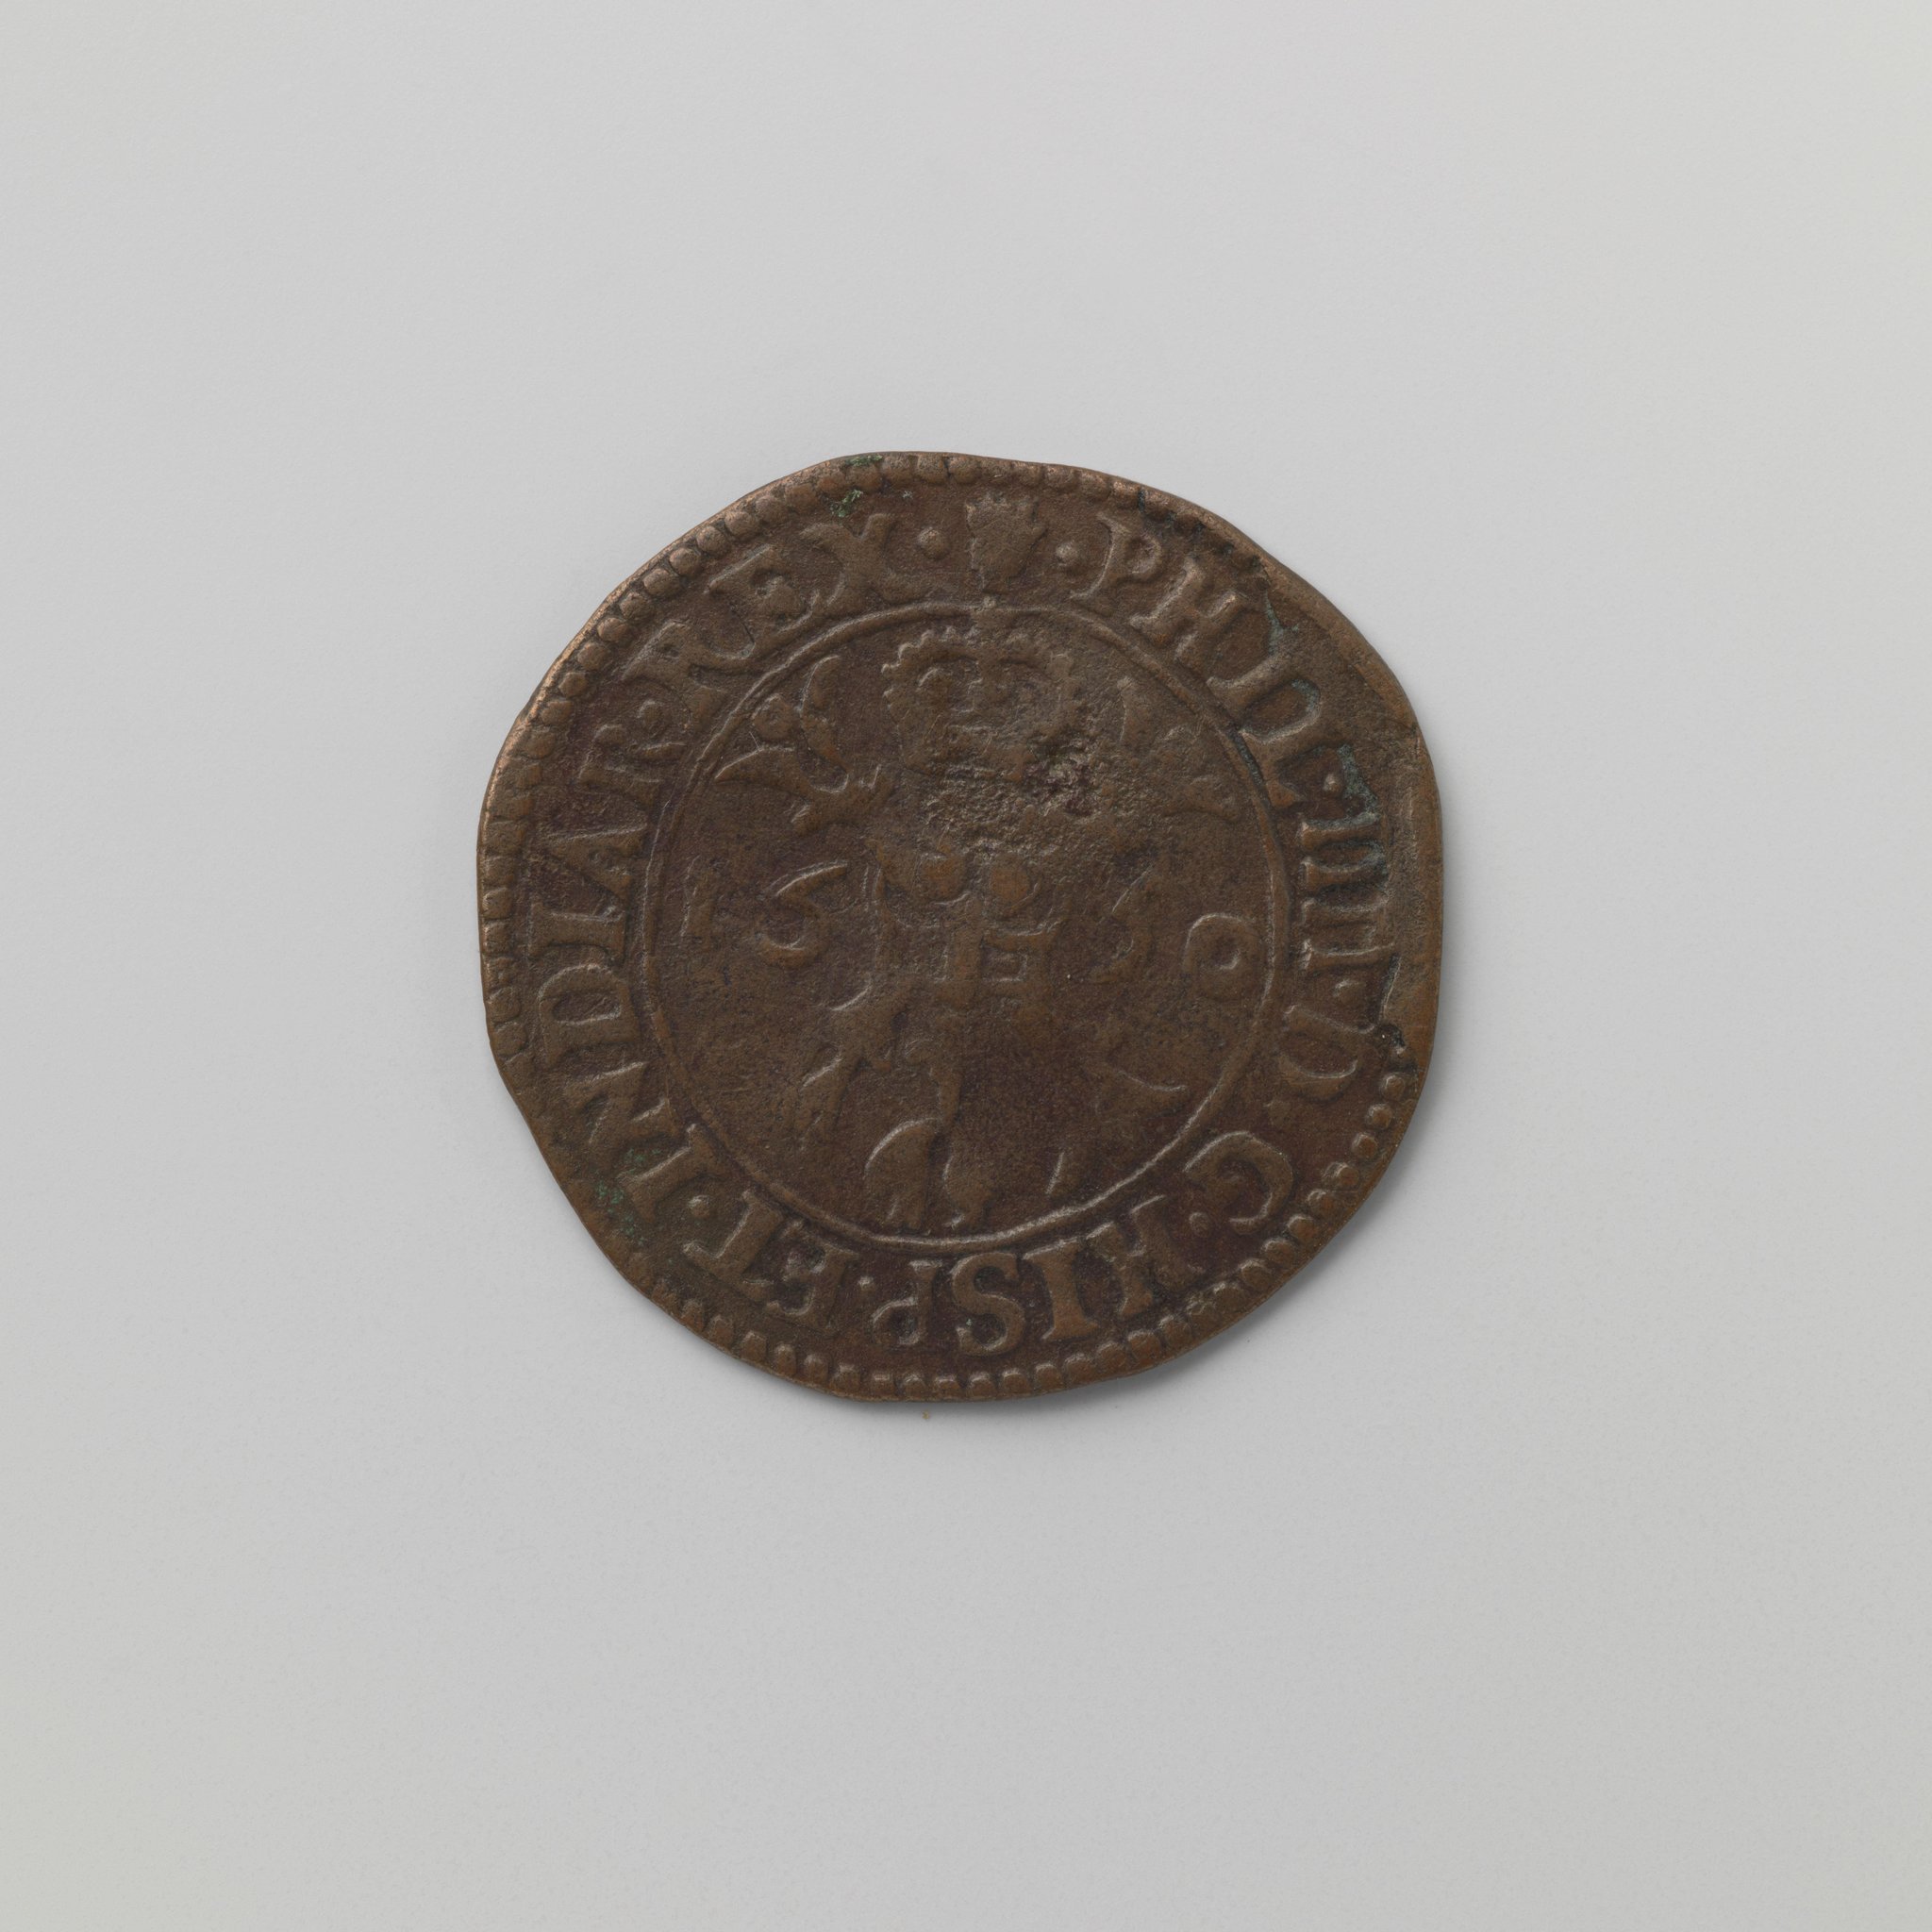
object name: coin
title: Duit uit Brabant van Philips IV, 1650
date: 1650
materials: copper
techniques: striking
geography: antwerp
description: Koperen munt. Voorzijde: gekroond versierd samengesteld wapenschild. Keerzijde: tussen jaartal vuurijzer op stokkenkruis Daarboven kroon, daaronder gulden vlies. Hand aan het begin van het omschrift.